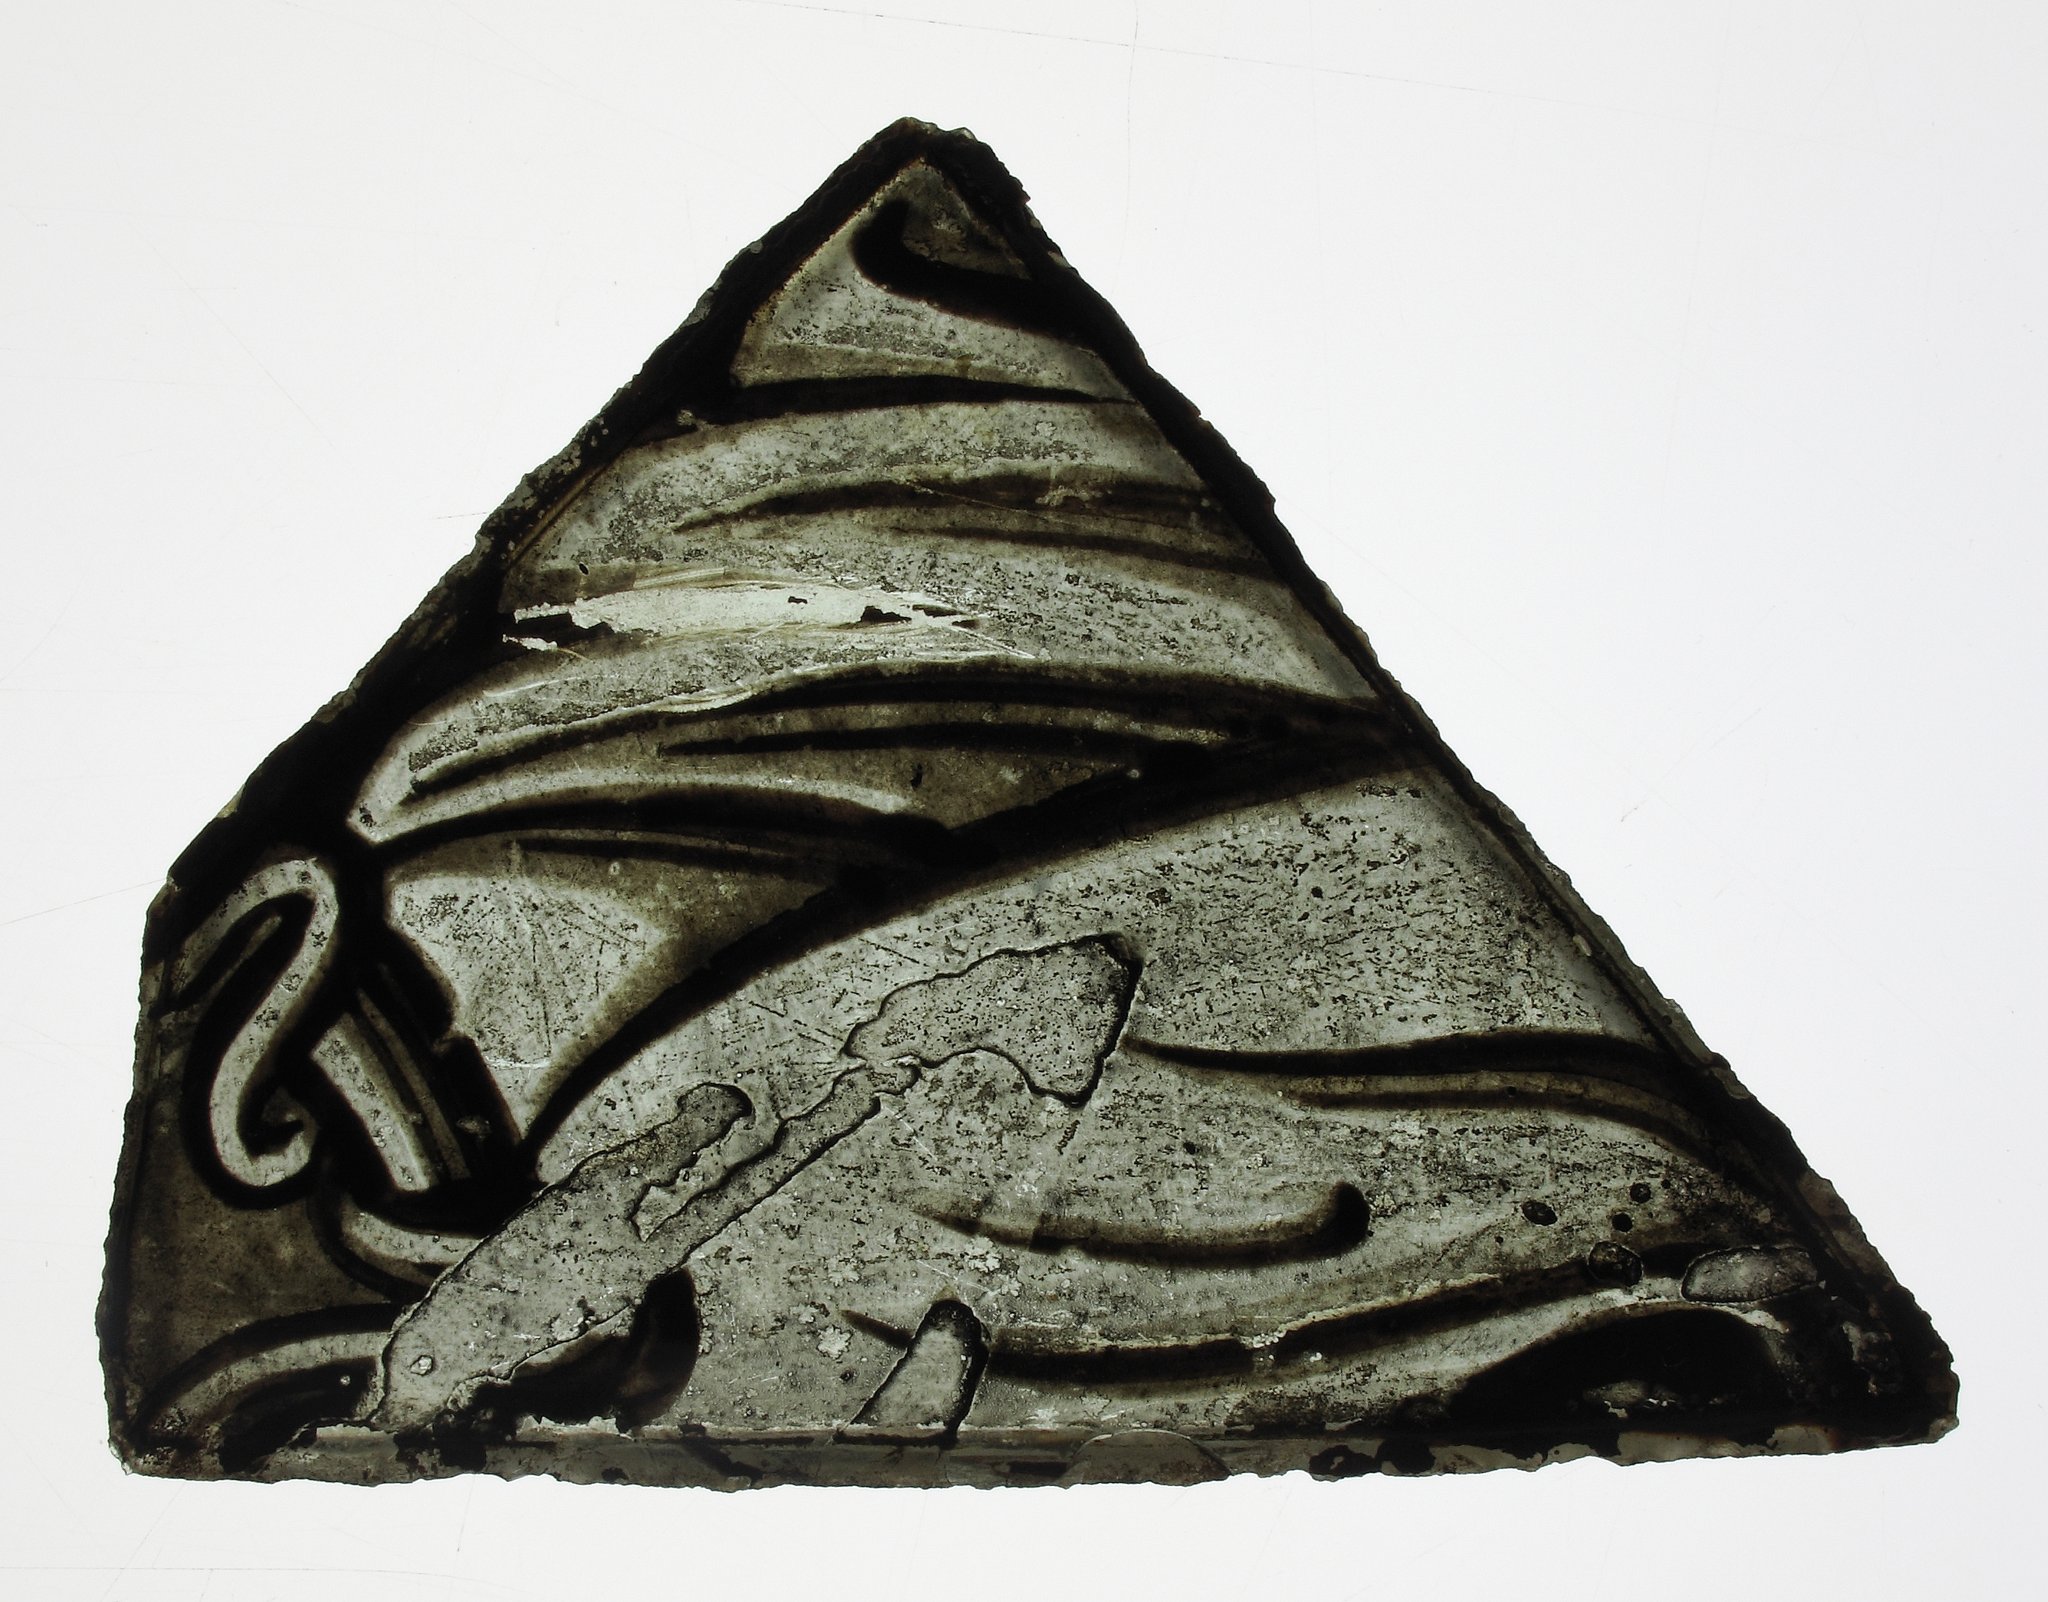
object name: fragment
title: Glass Fragment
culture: european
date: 1301-1400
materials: glass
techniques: leading